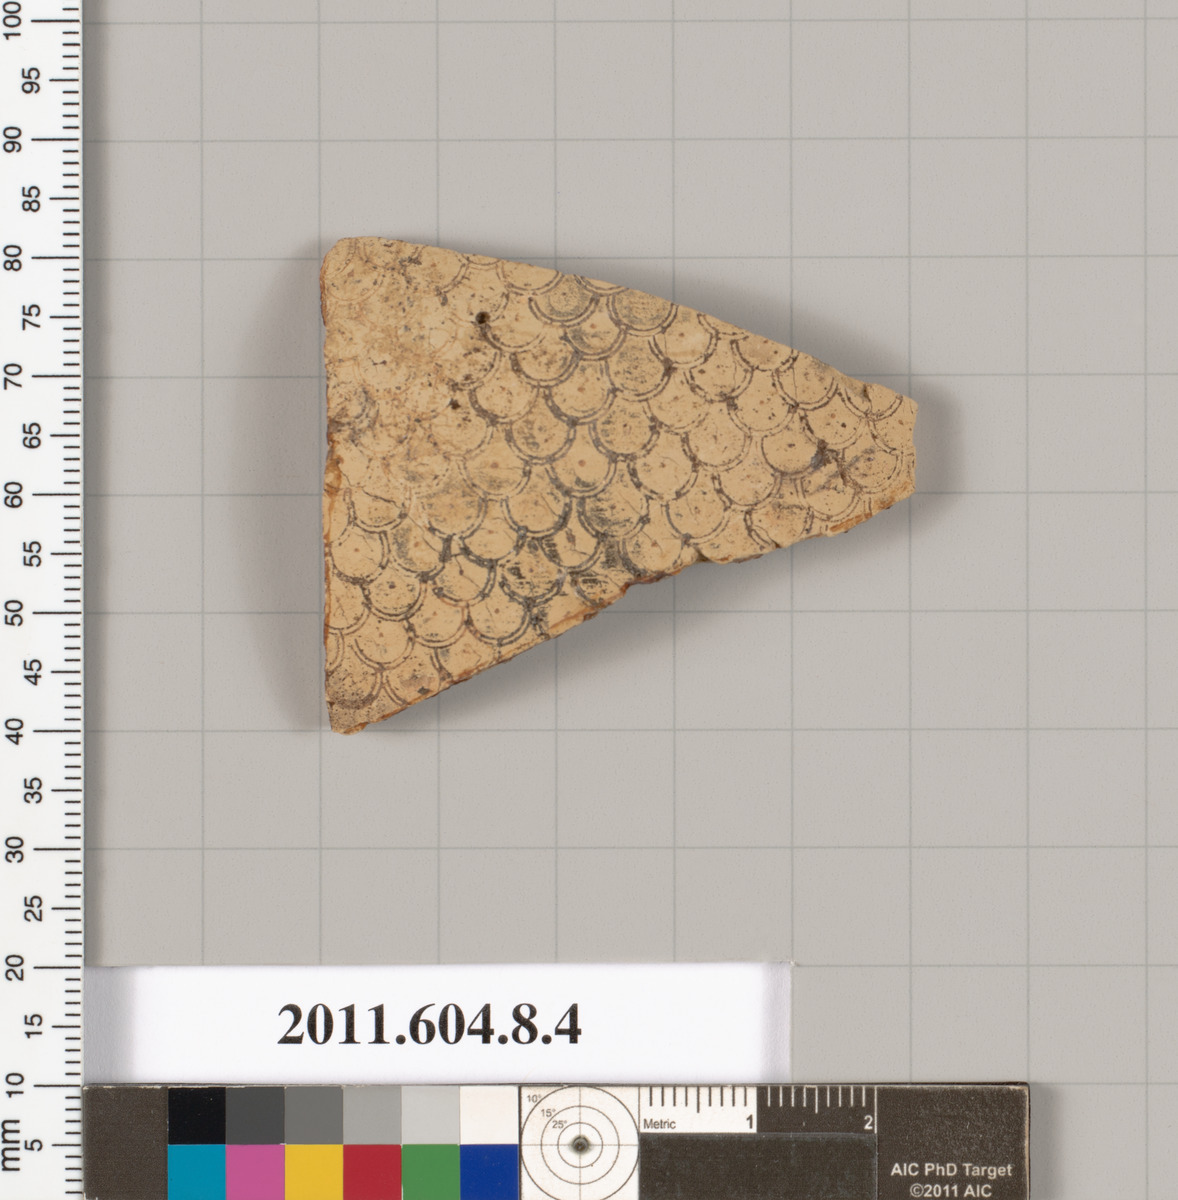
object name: undetermined open shape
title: Terracotta fragment of an open vase?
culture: greek, corinthian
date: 567-535 BCE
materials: terracotta